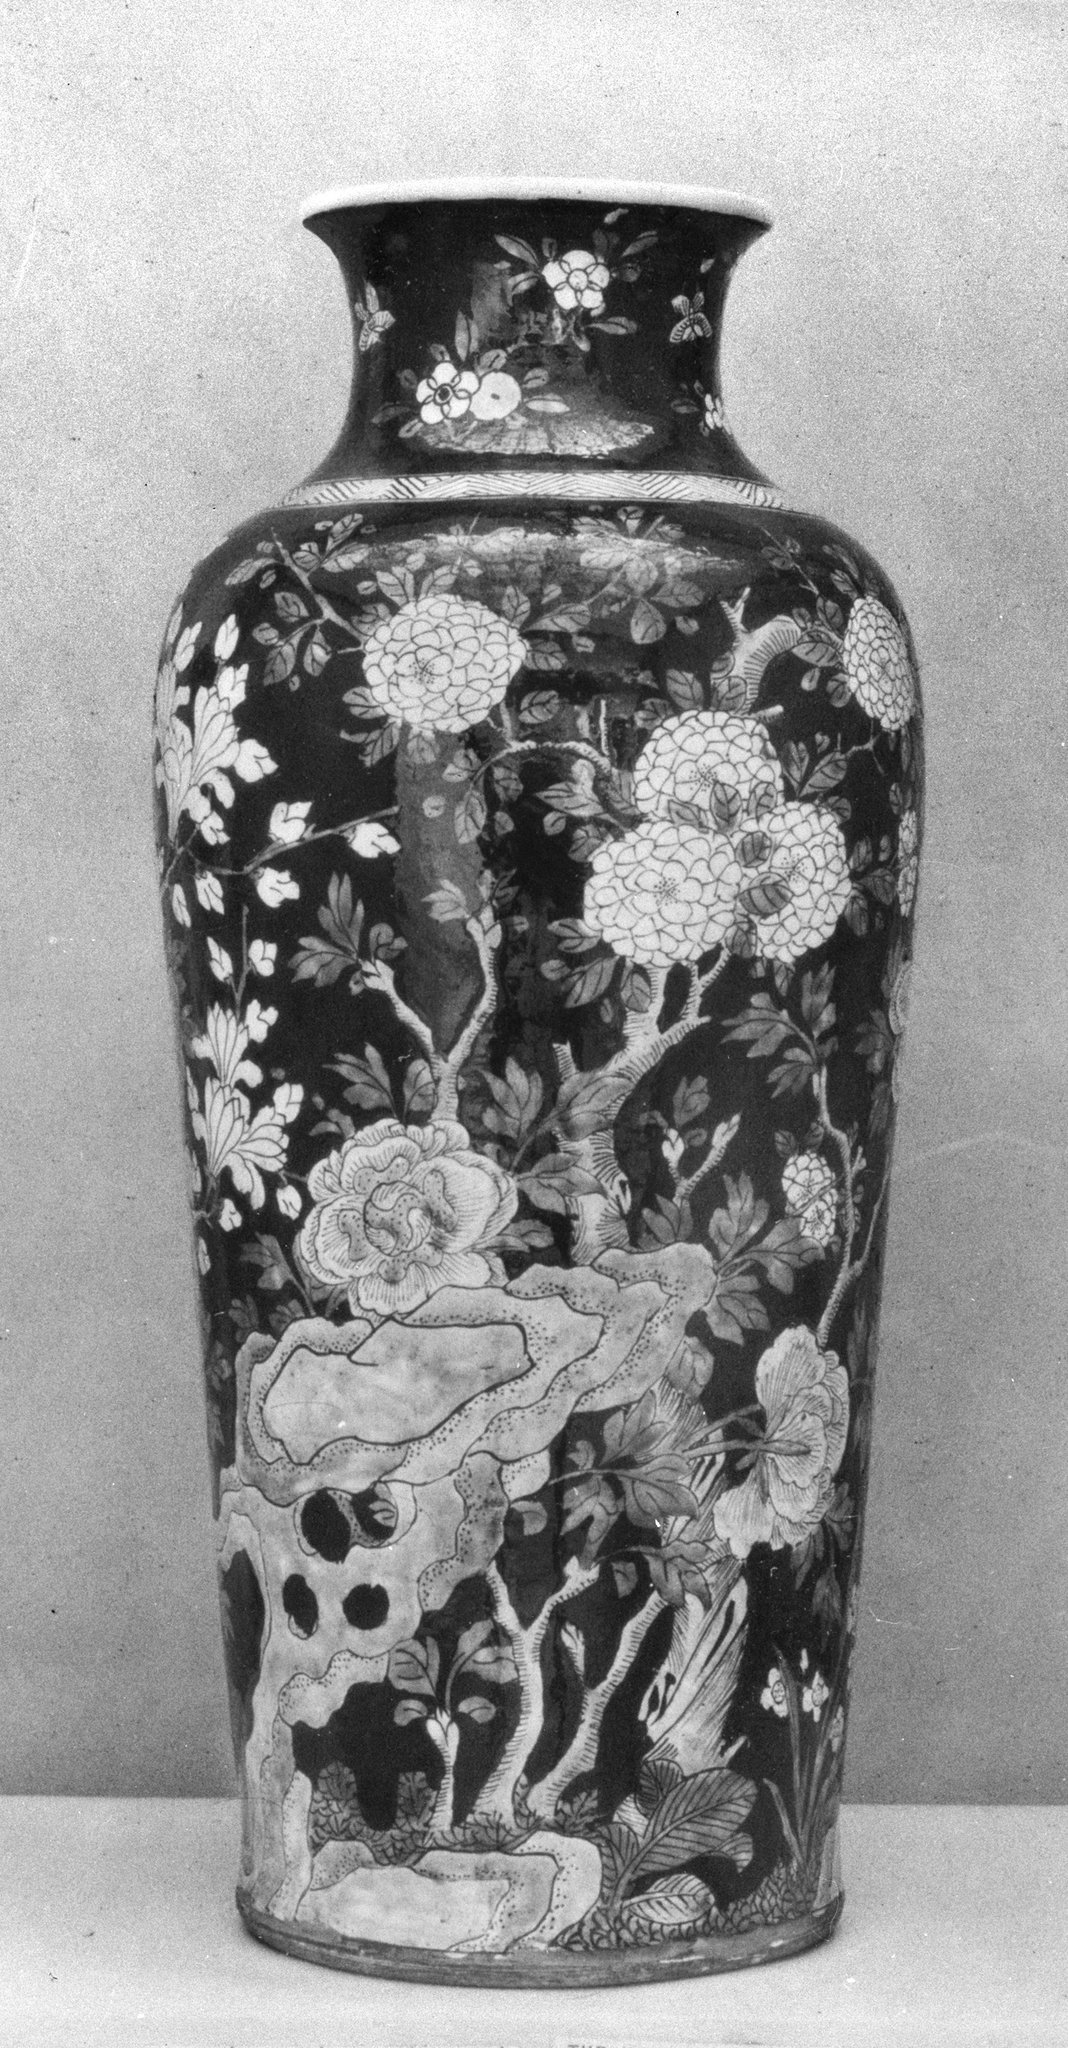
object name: vase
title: Vase with flower and rock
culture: chinese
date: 1801-1900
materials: enamel, porcelain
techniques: painting, polychrome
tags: flowers